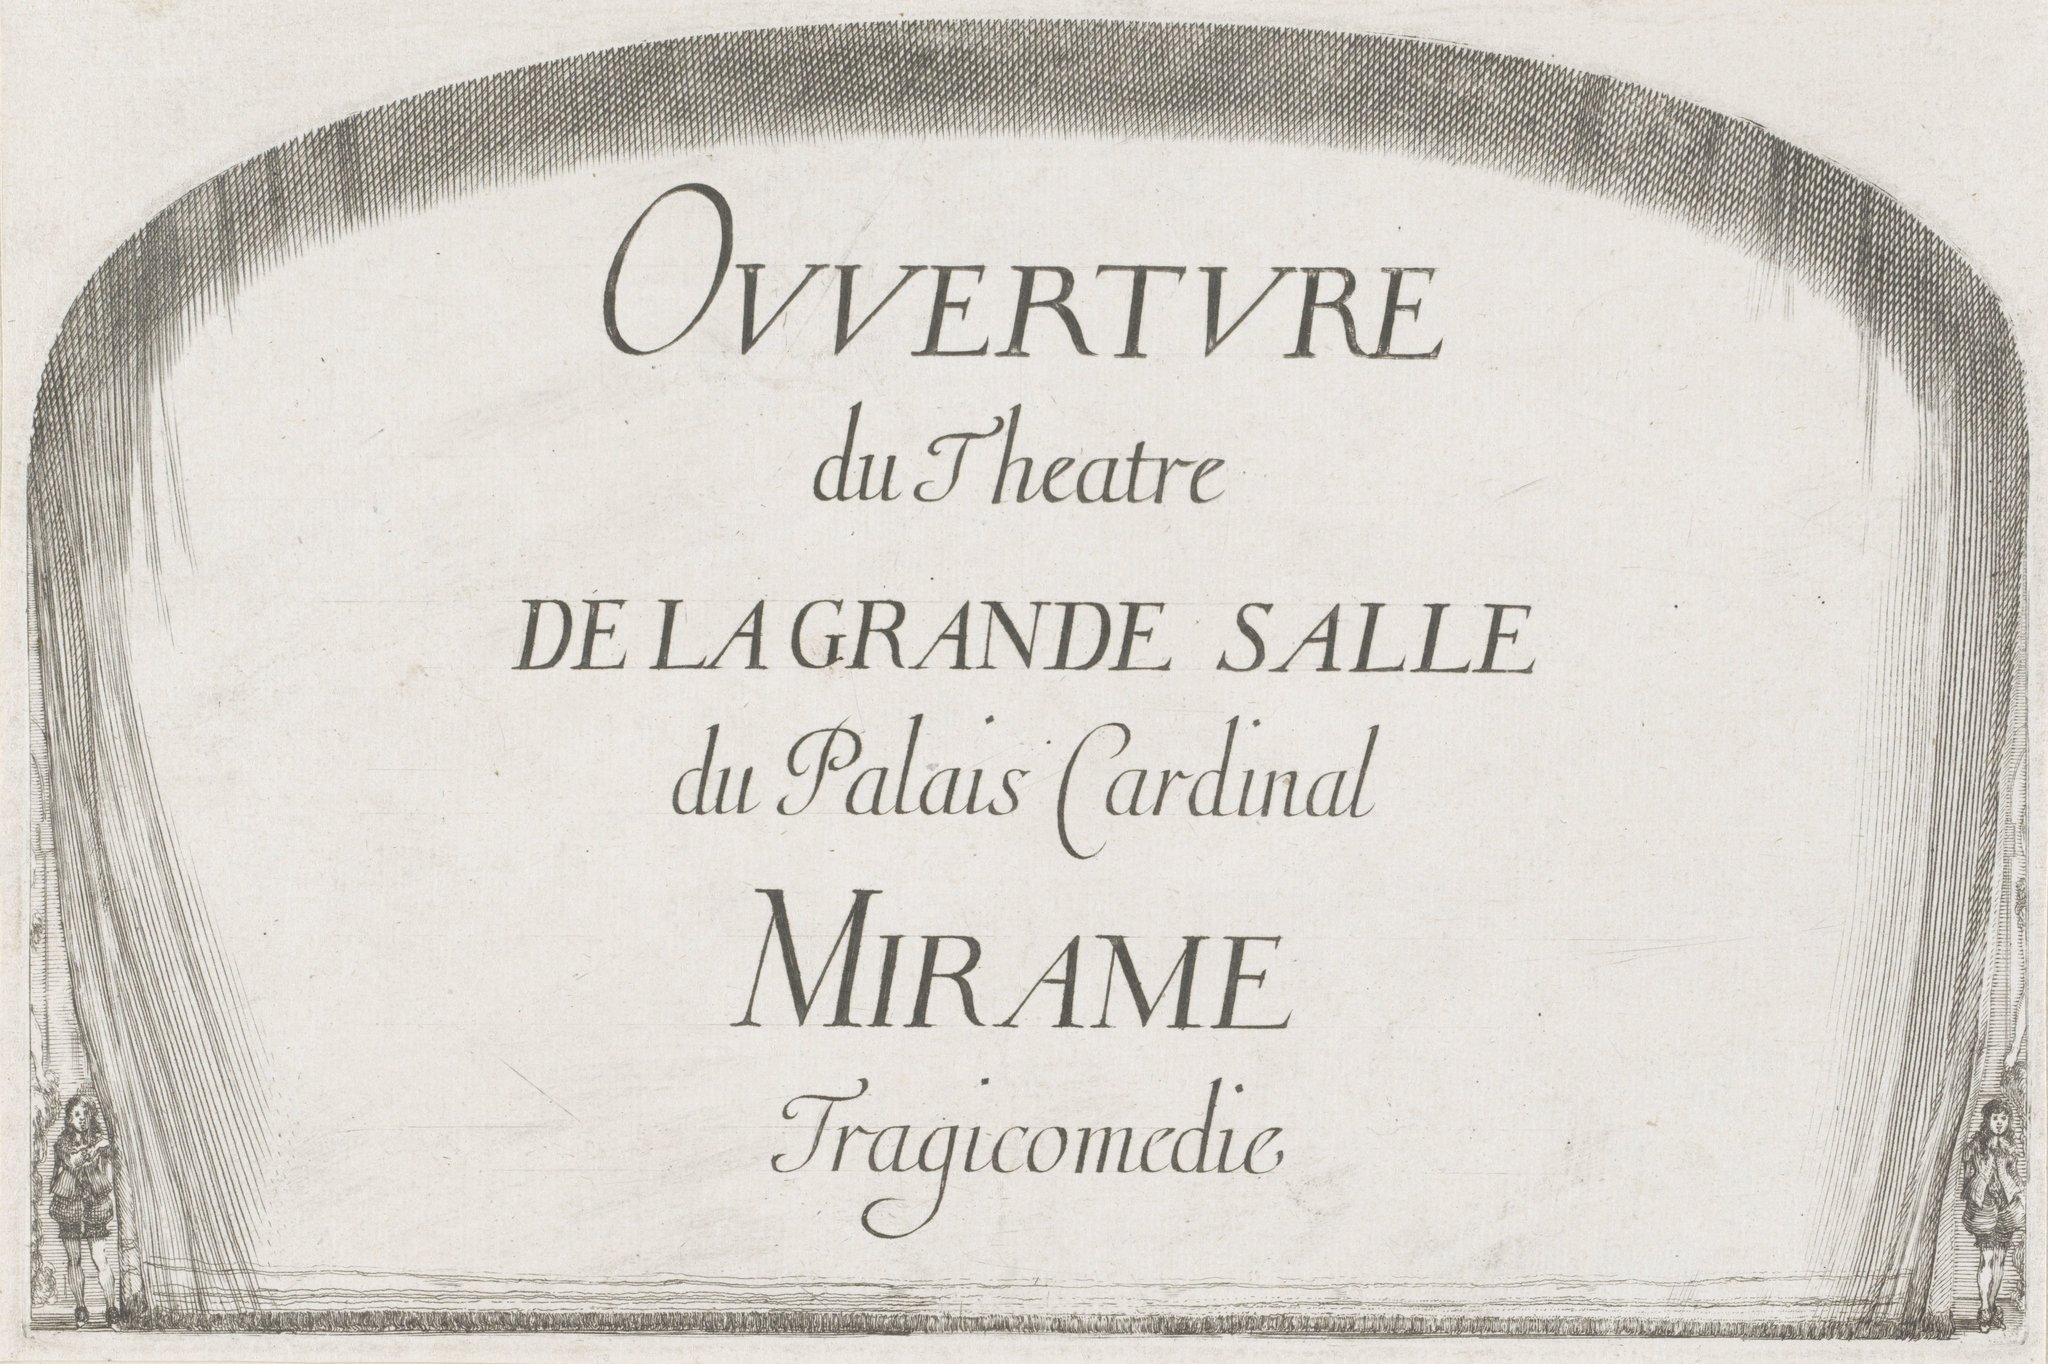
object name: ornament print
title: Ouverture du theatre de la grande salle du palais cardinal Mirame tragicomedie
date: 1641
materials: paper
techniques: etching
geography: france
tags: set, scenery ~ stage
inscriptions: collector's mark: Lugt 240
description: Prent uit een reeks van zes prenten van decors voor de tragi-komedie Mirame, geschreven door Jacques Desmarets de Saint-Sorlin.